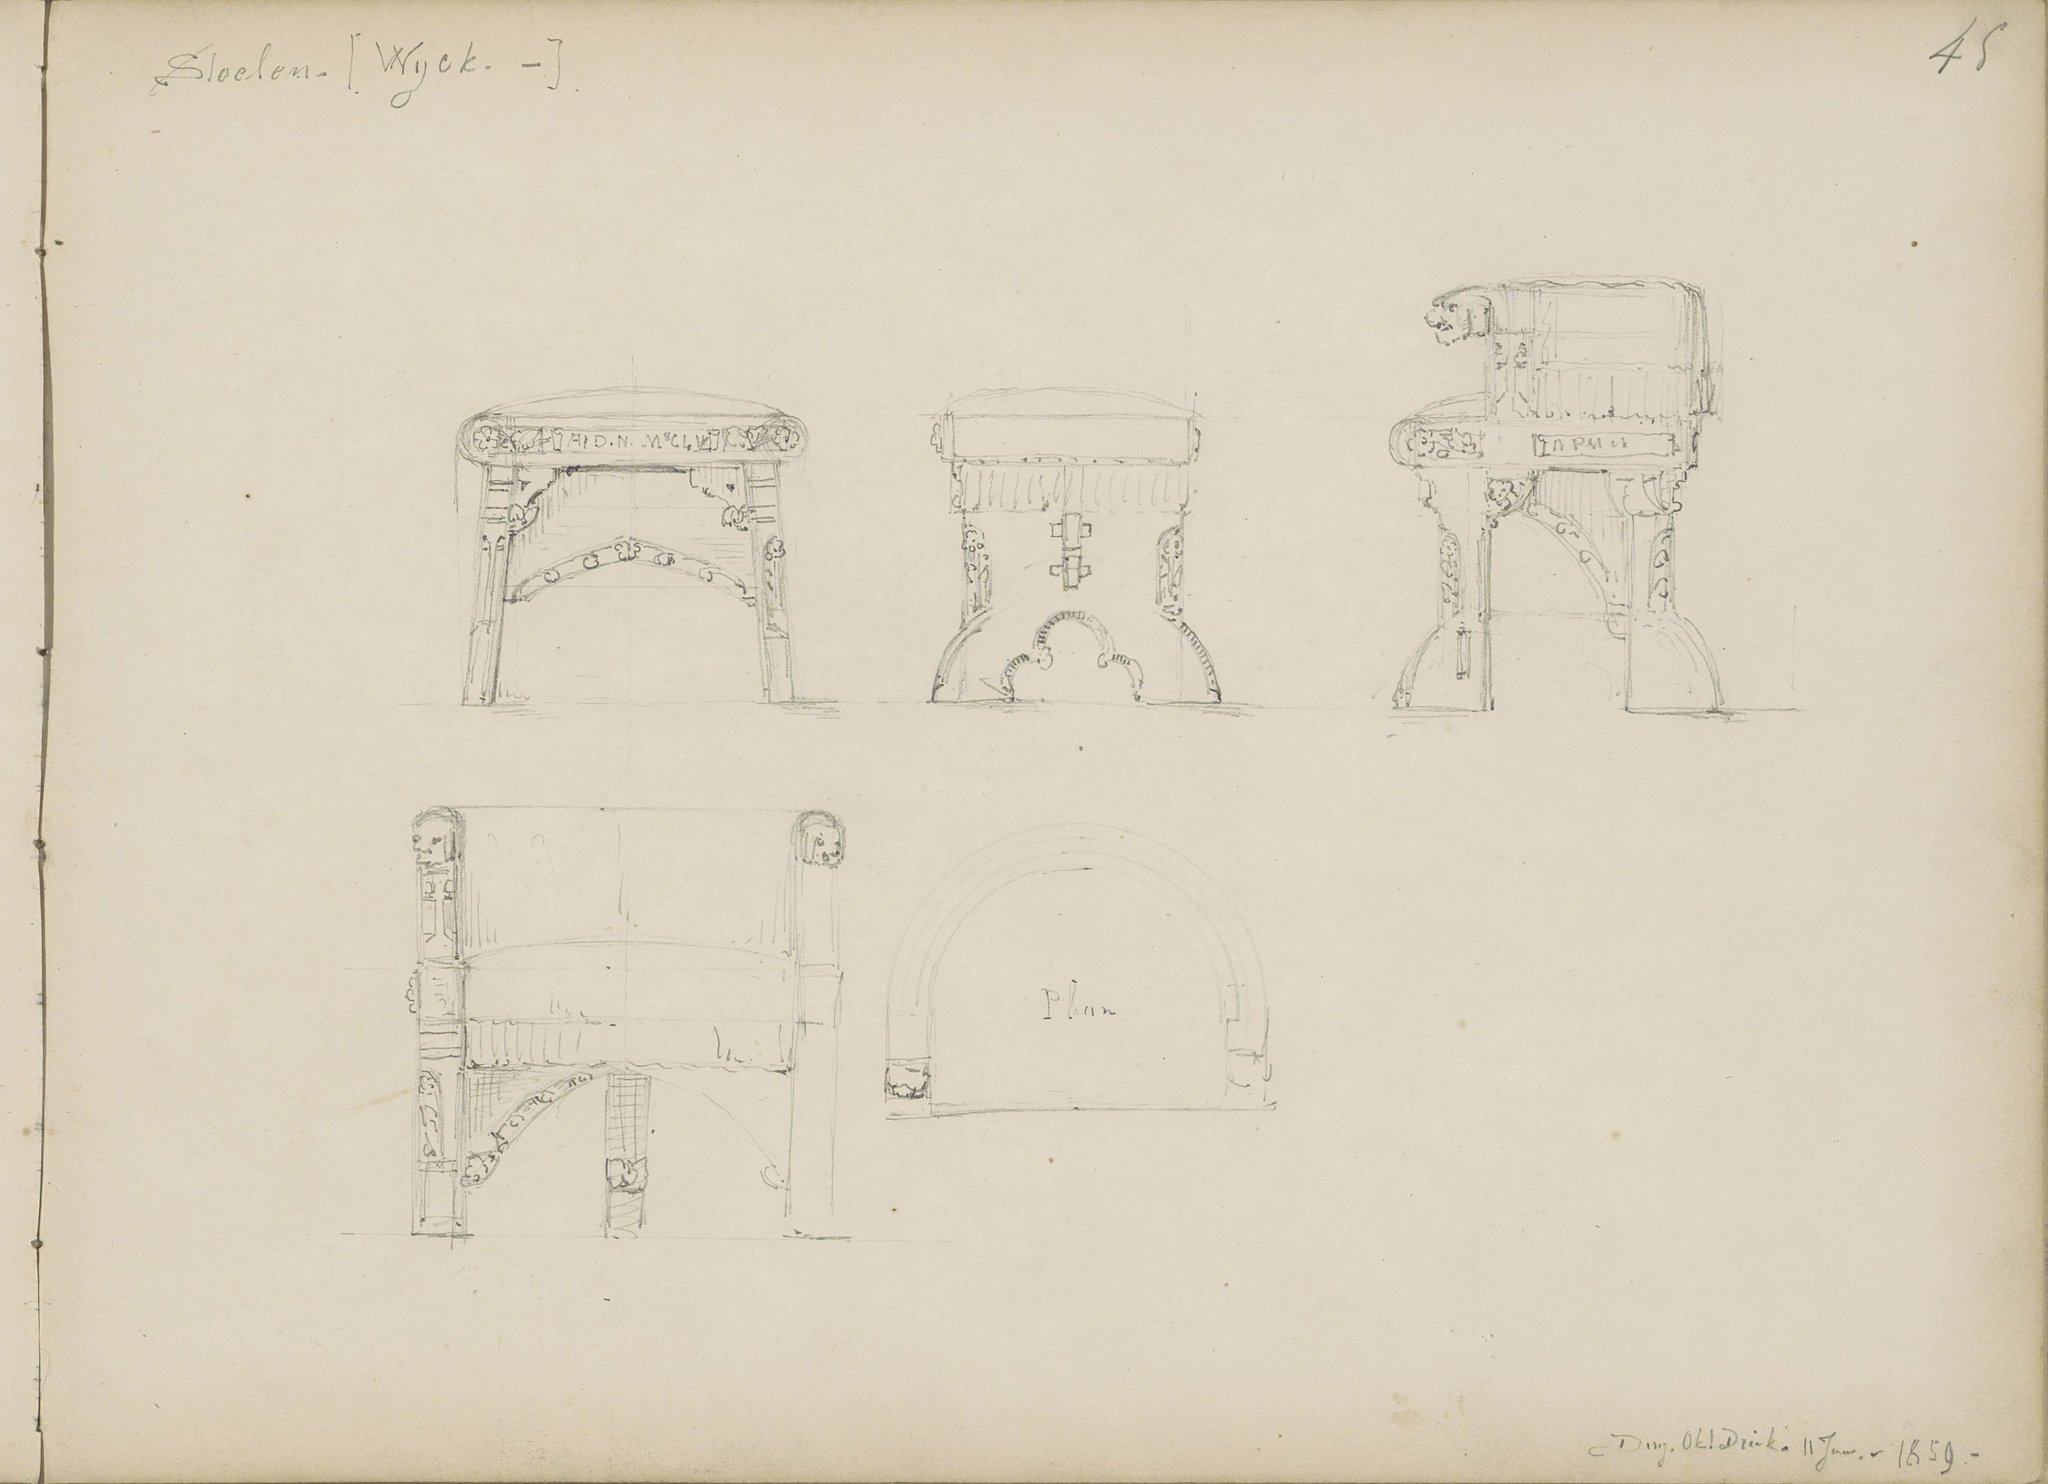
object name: sketchbook leaf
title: Stoelen, Wijck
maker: pierre joseph hubert cuypers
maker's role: draughtsman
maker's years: 1827-1921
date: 1801-1859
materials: paper, pencil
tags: table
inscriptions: date and inscription: ‘Stoelen [Wijck.-]/ C D[...]g OKlDrick? 11 Jan. v 1859.-’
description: Mogelijk ontwerpen voor stoelen voor de St. Martinuskerk te Wijck, die in de periode 1857-1860 naar ontwerp van Cuypers werd gebouwd.